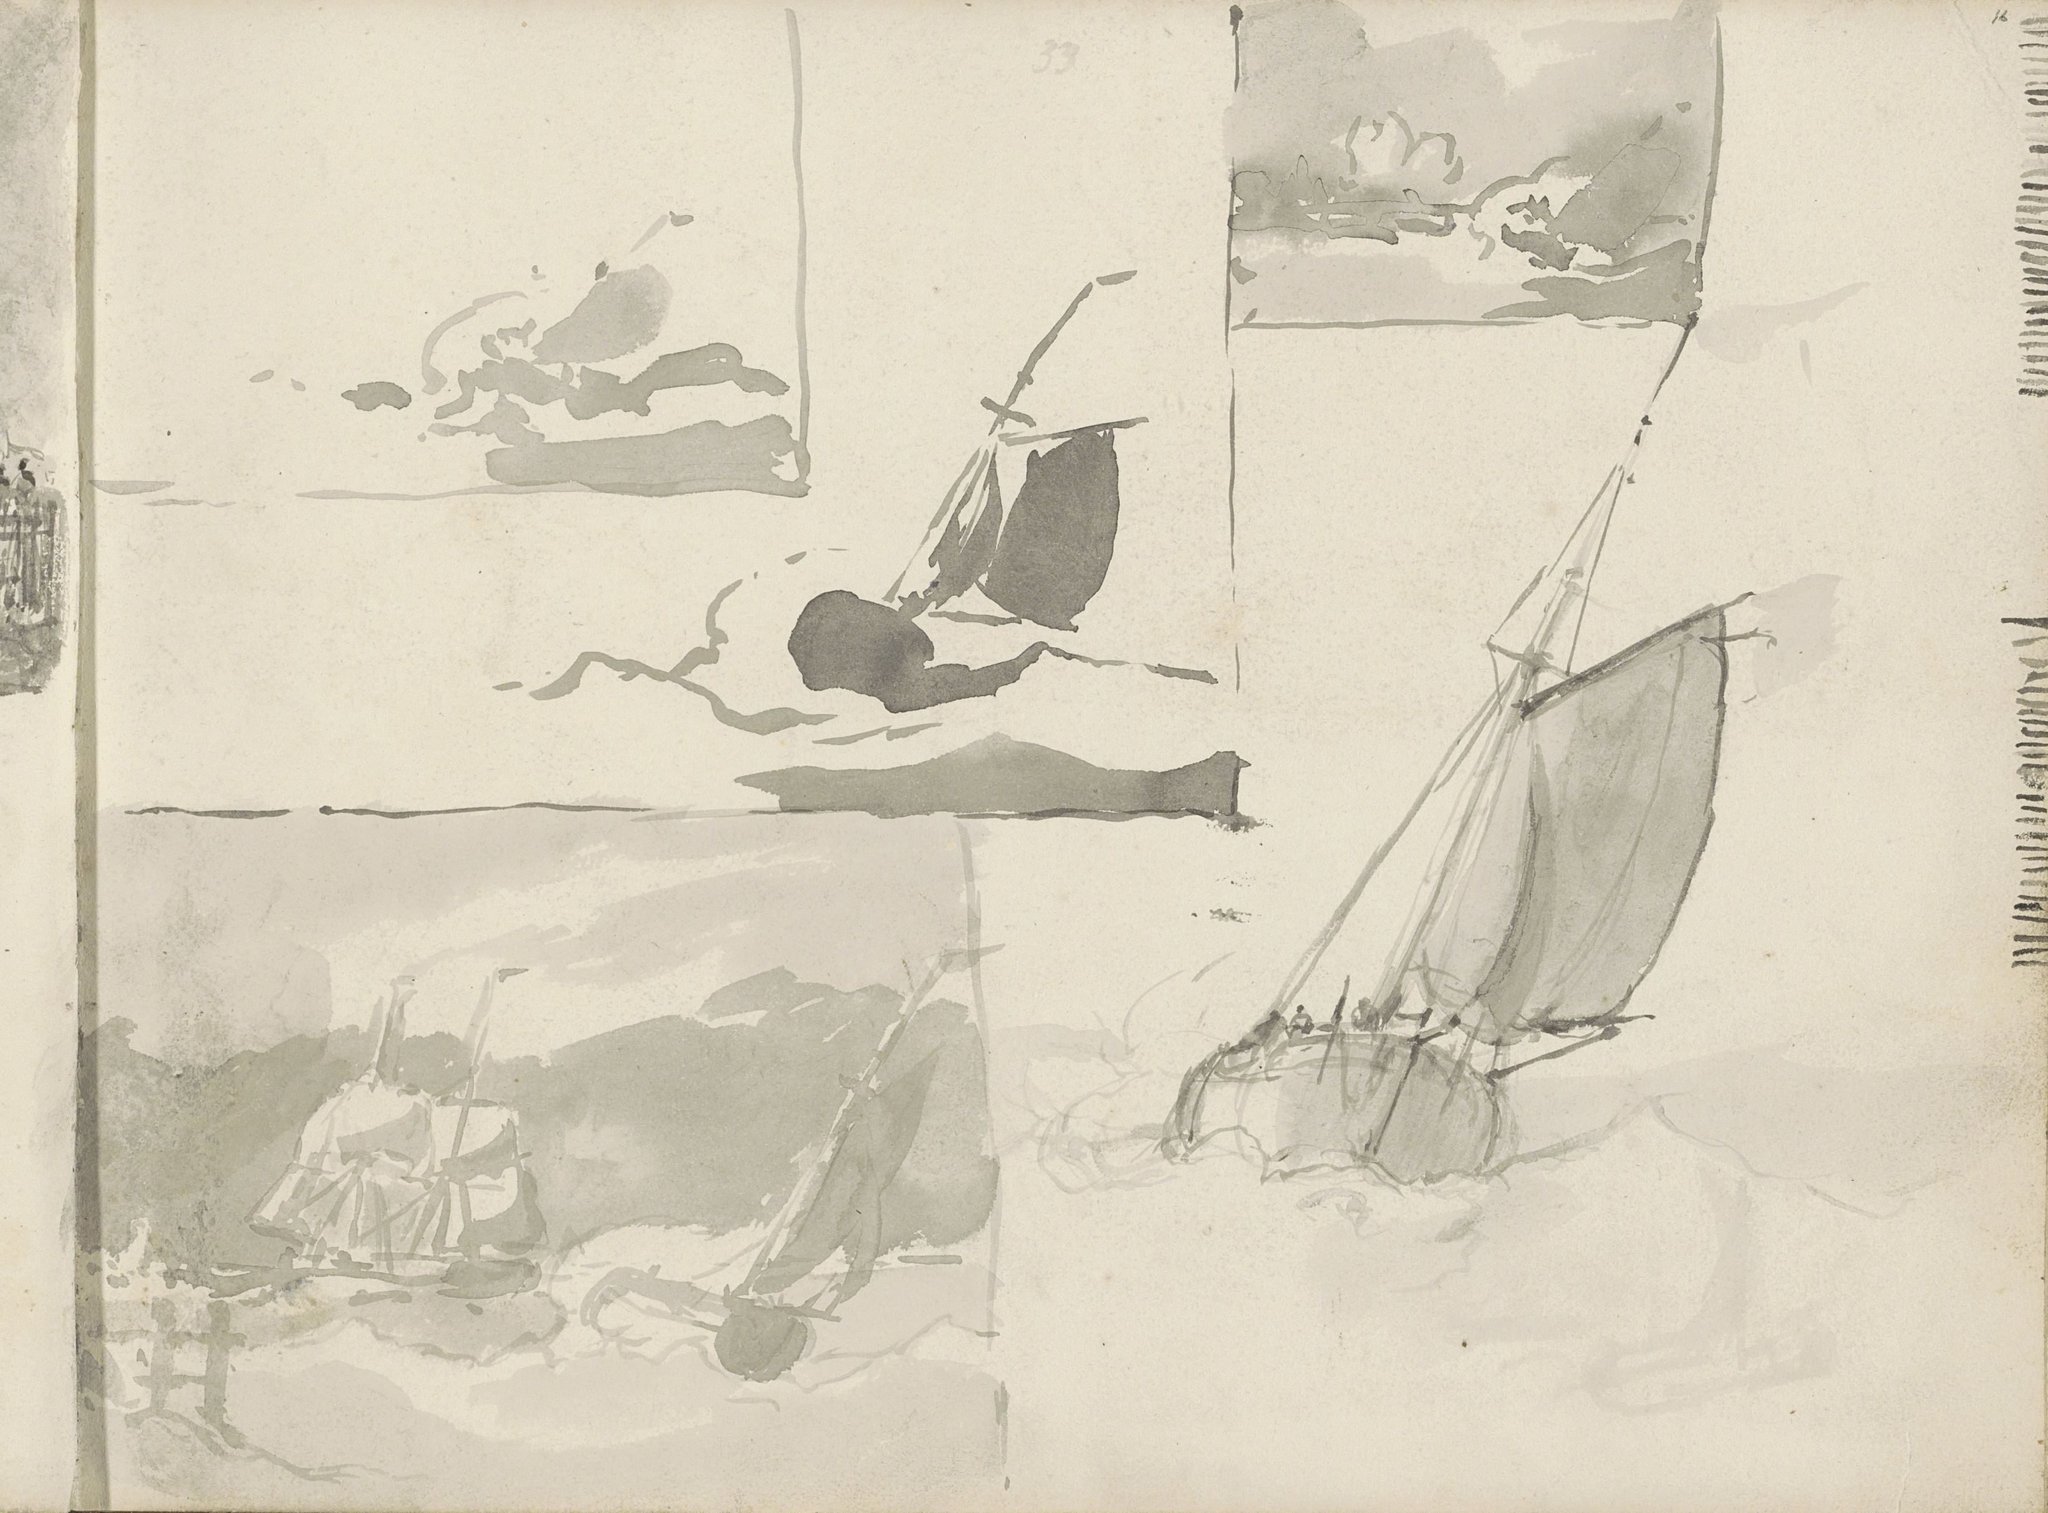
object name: sketchbook leaf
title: Studieblad met zeegezichten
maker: petrus johannes schotel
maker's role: draughtsman, painter, print maker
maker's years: 1808-1865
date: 1825-1875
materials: paper, watercolor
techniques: brush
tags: sailing-ship, sailing-boat, sea (seascape)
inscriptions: number: ‘33’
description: Studies van zeilschepen op zee. Blad 16 recto uit een schetsboek met 44 bladen.